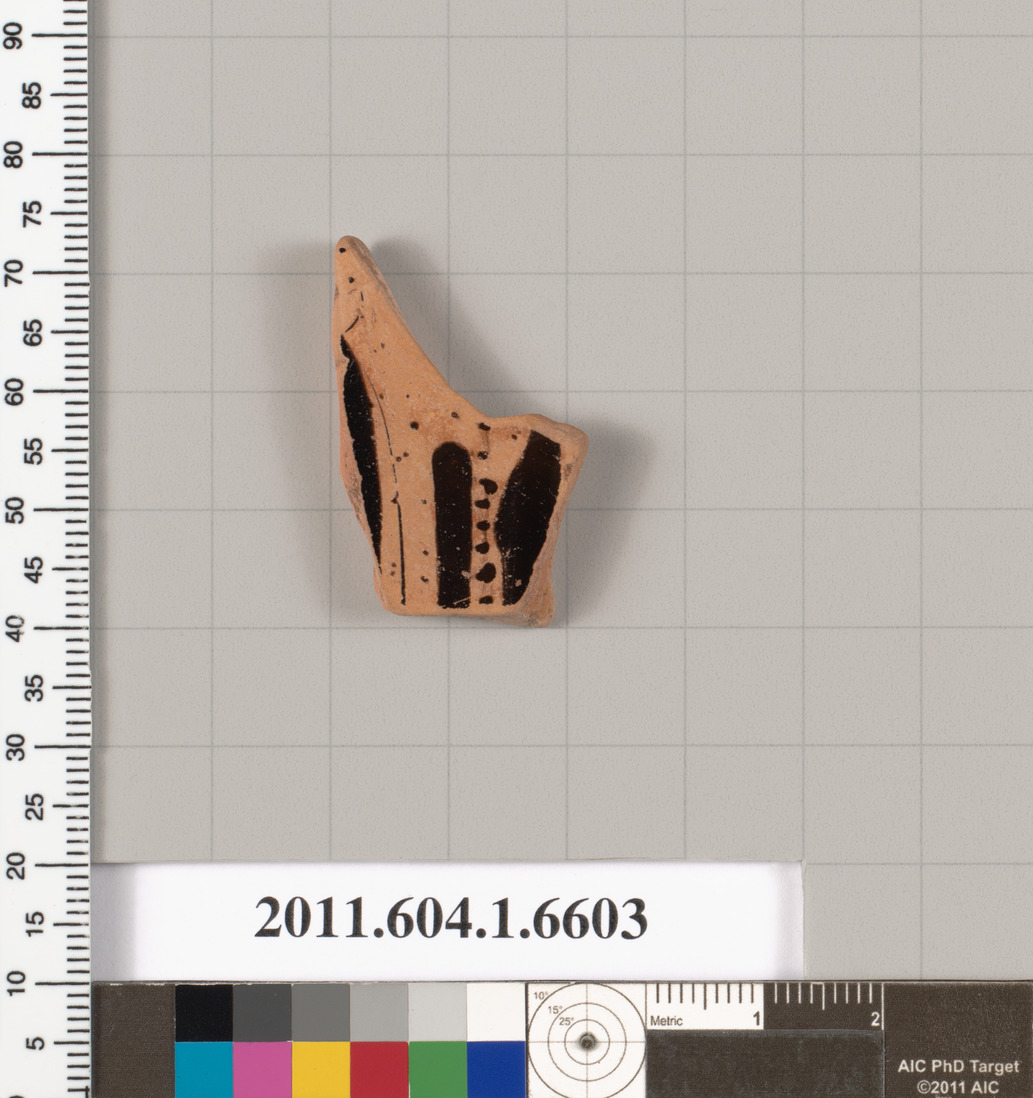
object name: kylix fragment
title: Terracotta fragment of a kylix (drinking cup)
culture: greek, attic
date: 490-480 BCE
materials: terracotta